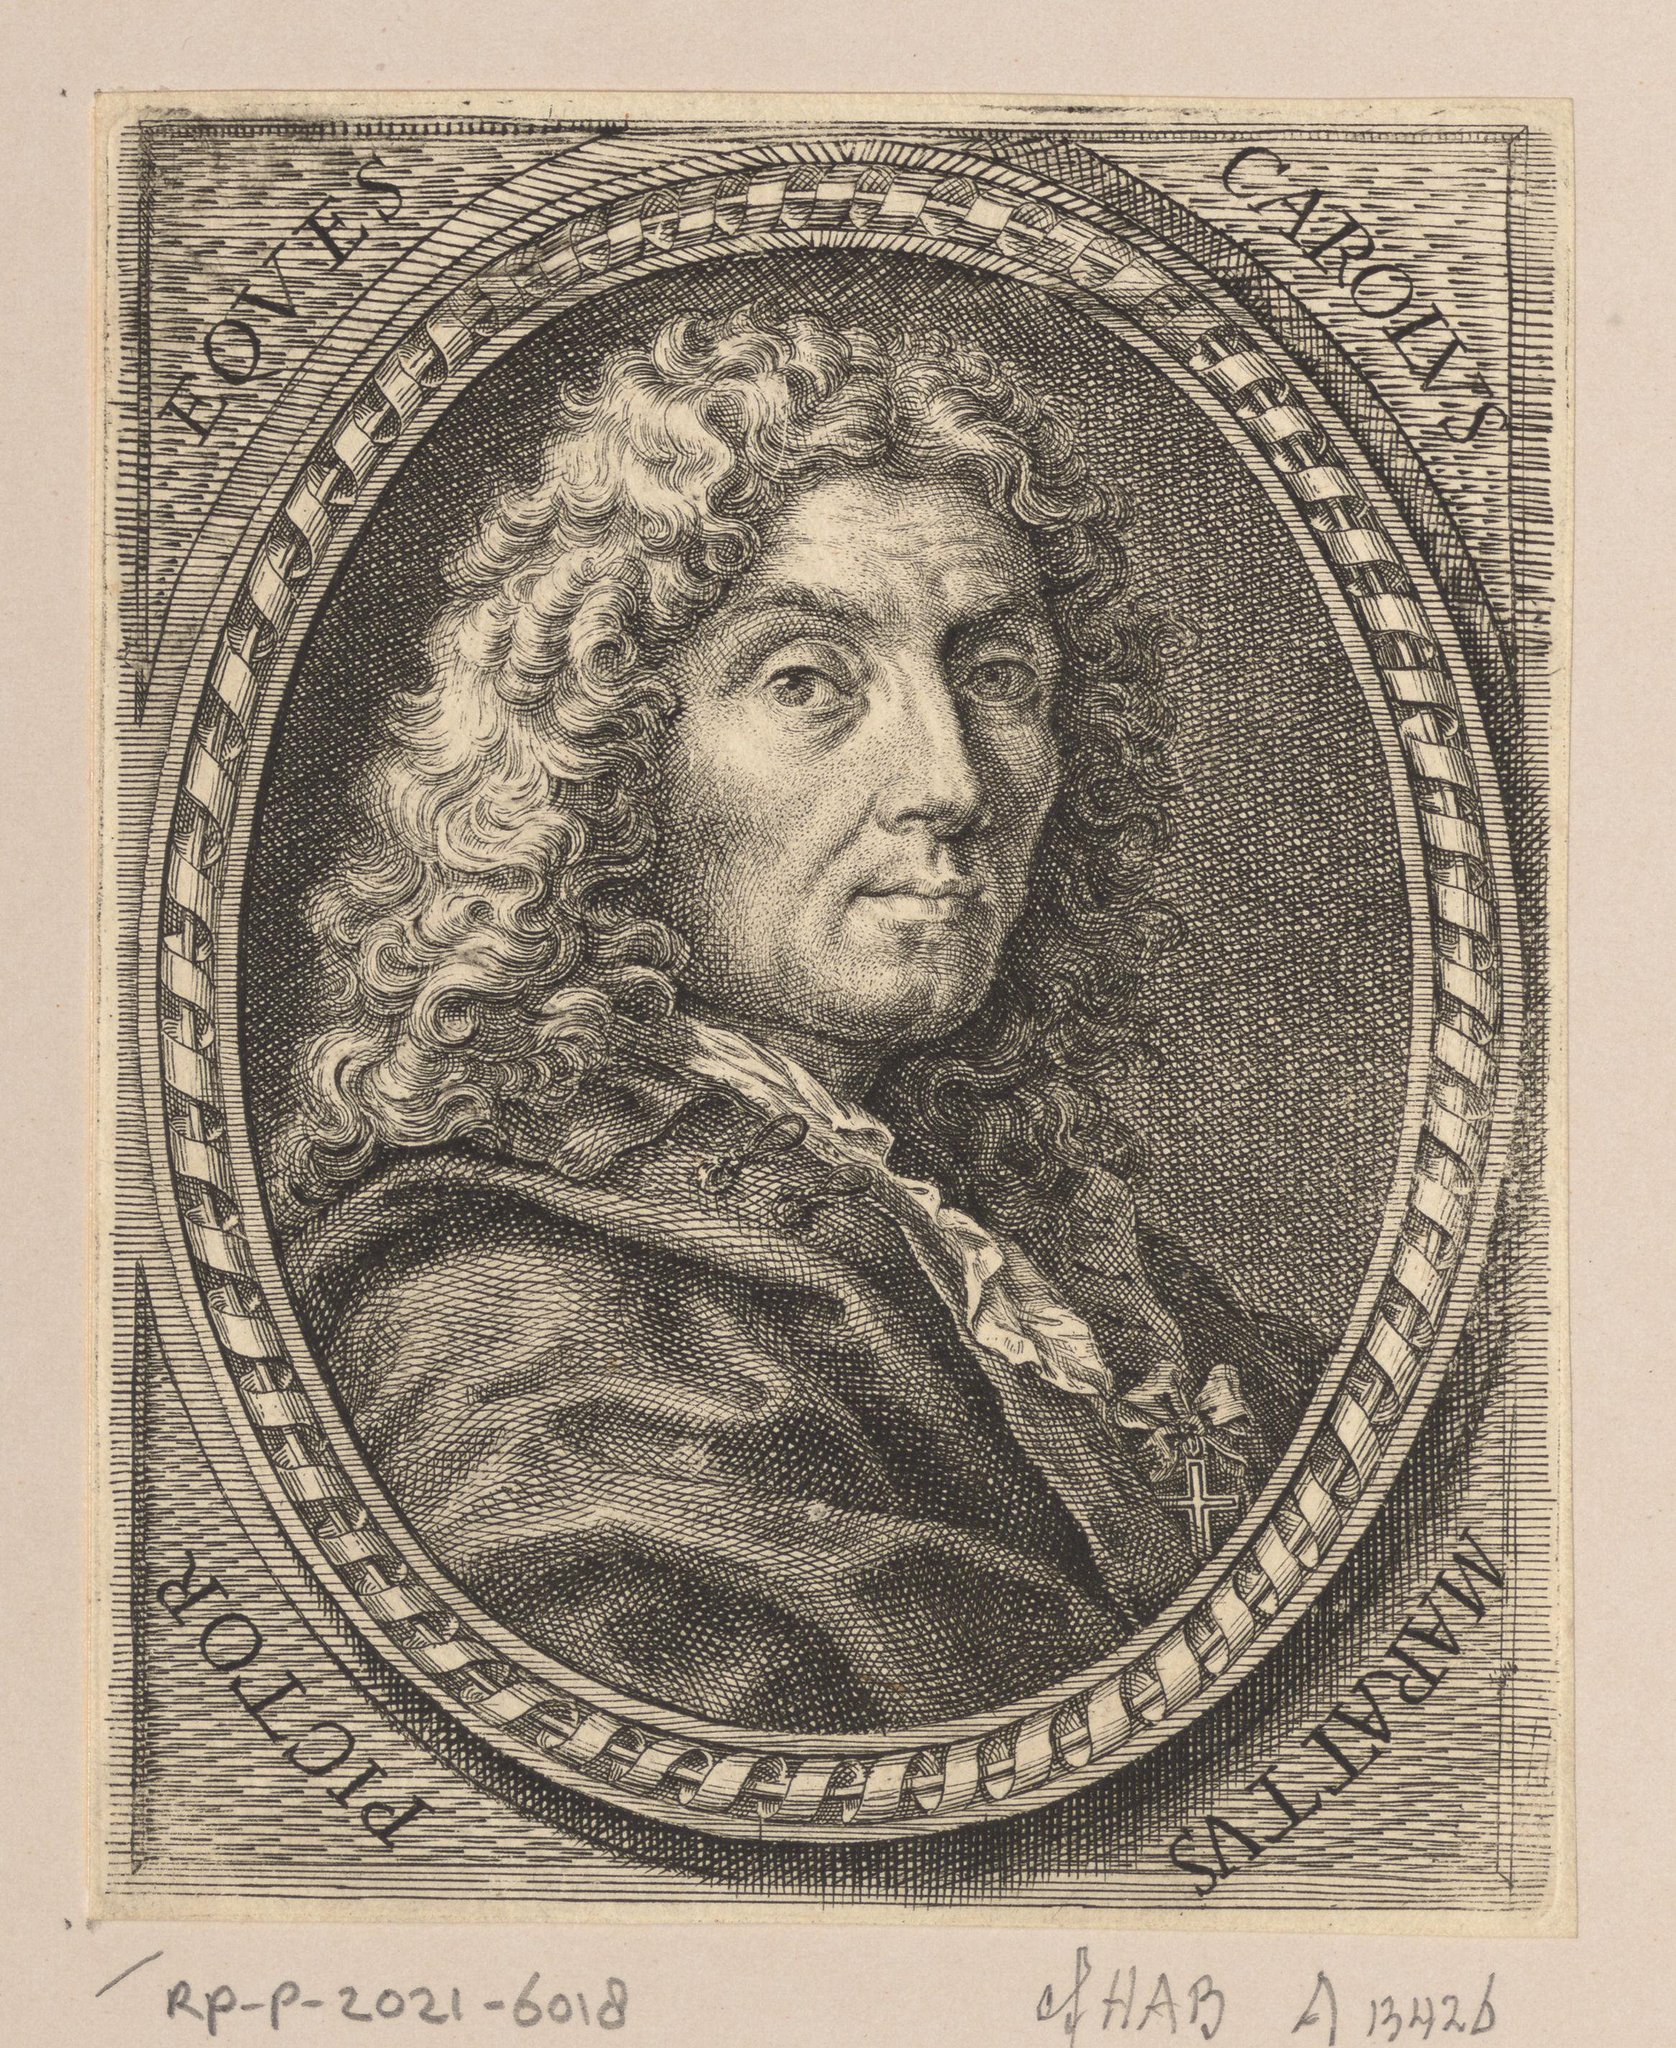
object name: print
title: Portret van Carlo Maratta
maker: Anonymous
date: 1704-1713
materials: paper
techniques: engraving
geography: italy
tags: rome, painter, print maker, draughtsman, carlo maratta, ornament ~ medallion, historical persons, portrait, self-portrait of painter